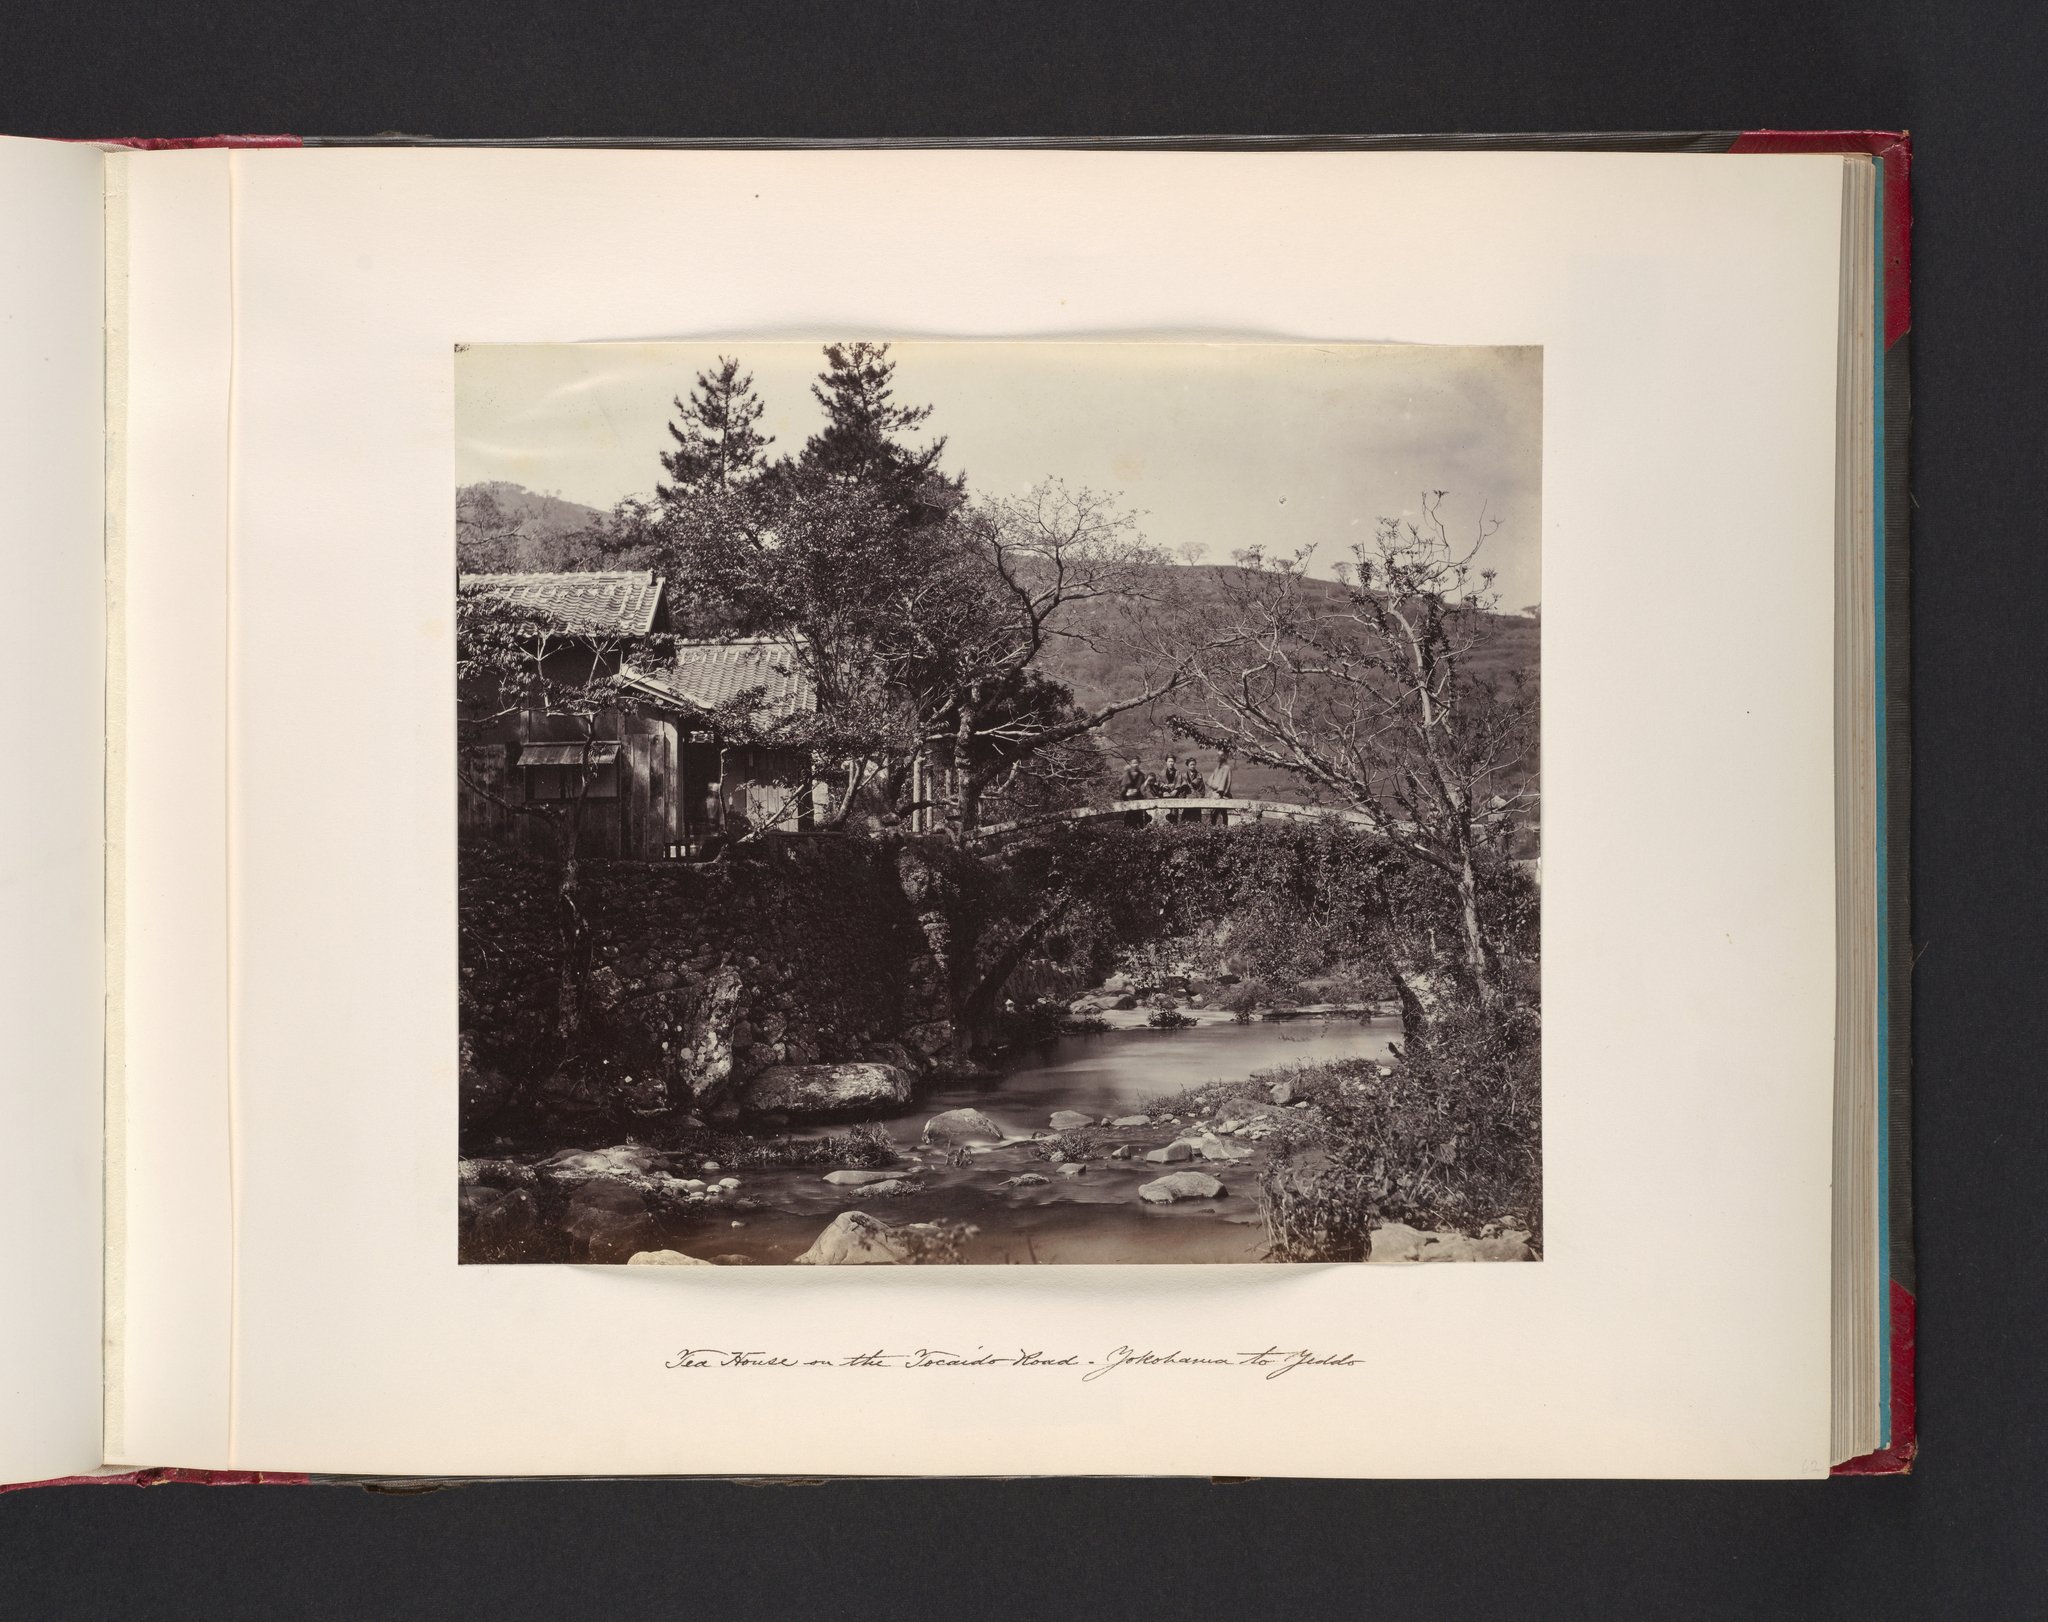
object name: photograph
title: Tea House on the Yokaido Road, Yokohama to Yeddo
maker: john thomson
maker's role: artist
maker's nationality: british, scottish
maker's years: 1837-1921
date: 1865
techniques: albumen silver print, glass negative